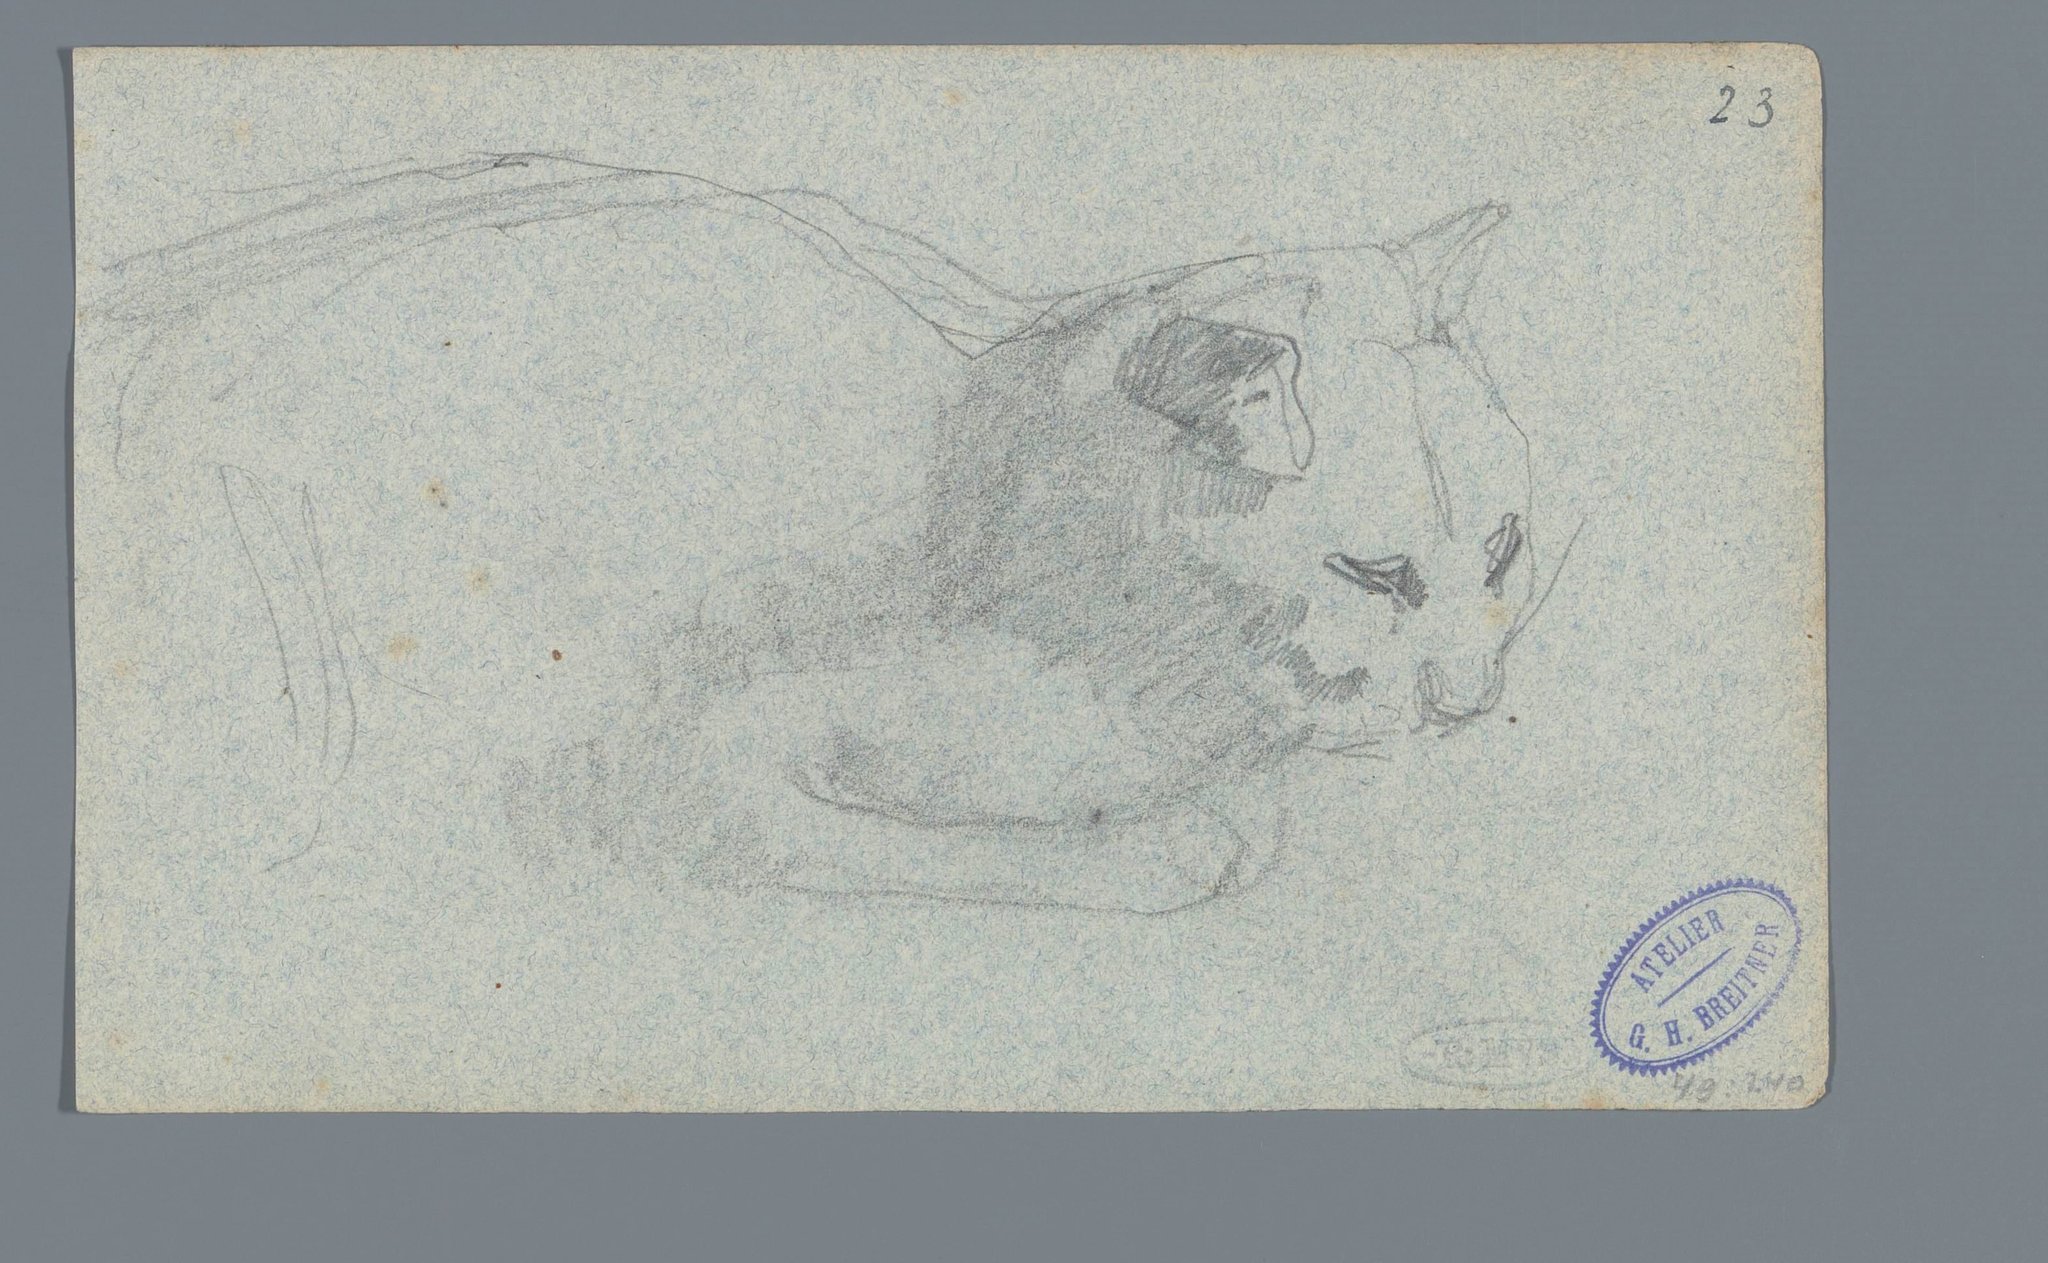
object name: drawing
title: Landschap met figuren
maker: george hendrik breitner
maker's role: draughtsman, painter, print maker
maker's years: 1857-1923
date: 1880-1882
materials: paper, pencil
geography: rotterdam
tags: landscapes in the temperate zone (+ landscape with figures, staffage)